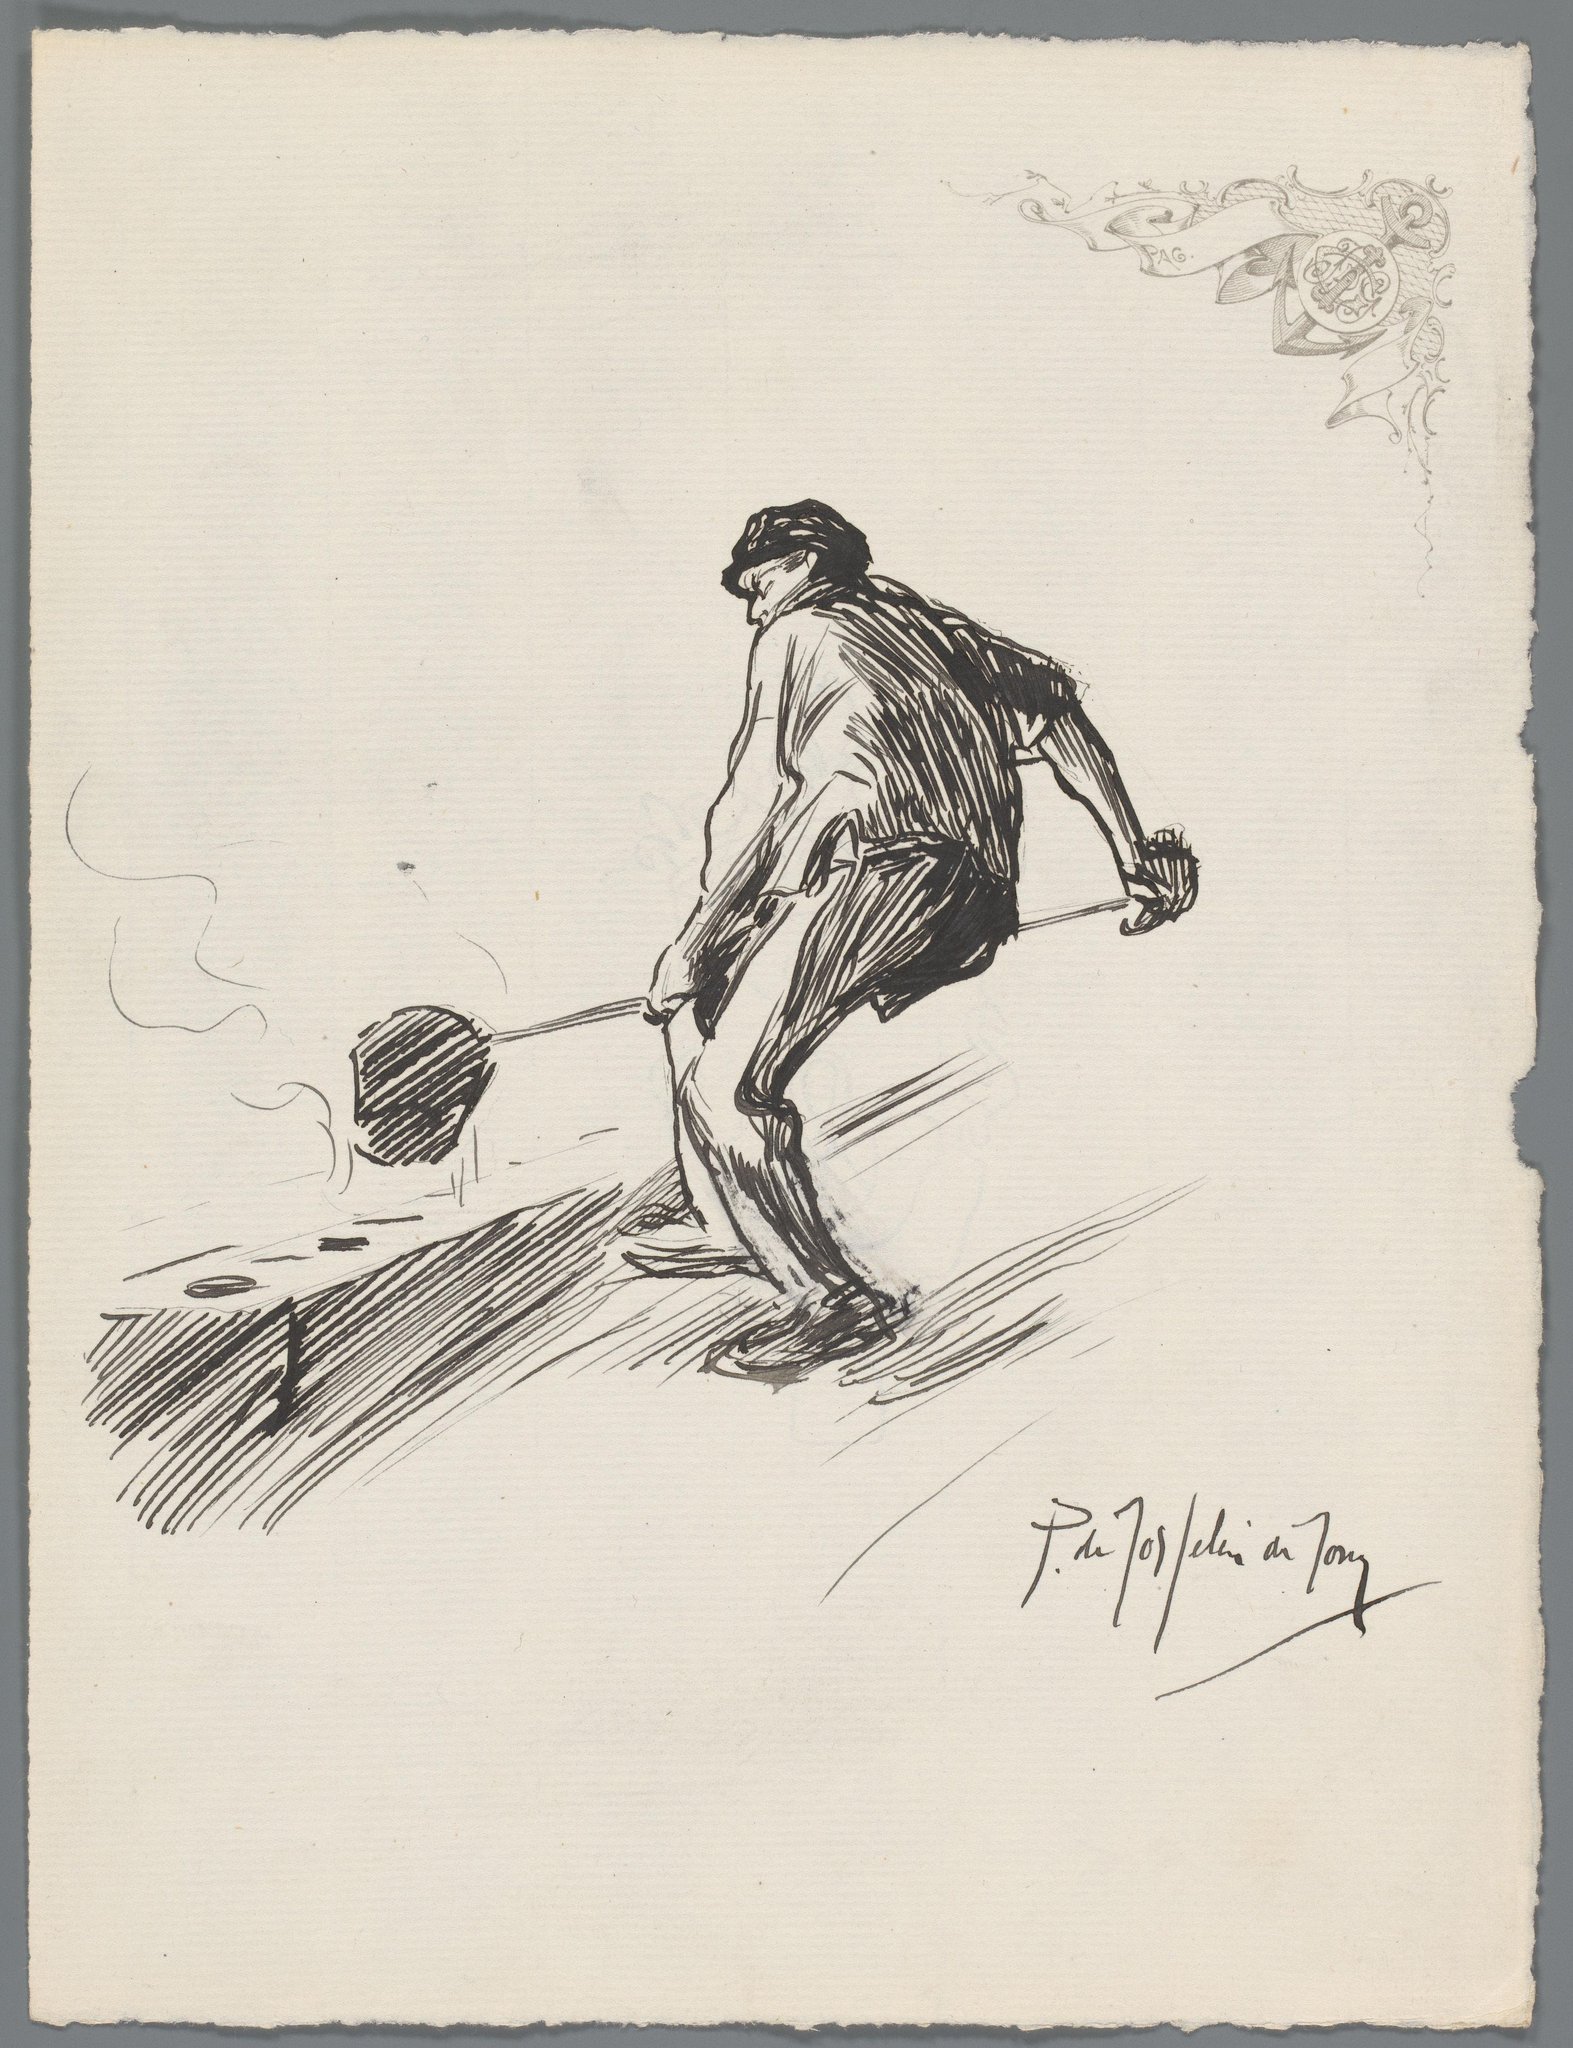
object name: drawing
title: Arbeider in staalfabriek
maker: pieter de josselin de jong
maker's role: draughtsman, painter, print maker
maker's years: 1861-1906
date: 1894-1906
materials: ink, paper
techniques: lithograph, pen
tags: iron and steel industry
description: Tekening op een blad met gepersonaliseerde decoratie in de vorm van een anker met monogram, met ruimte voor een paginanummer.